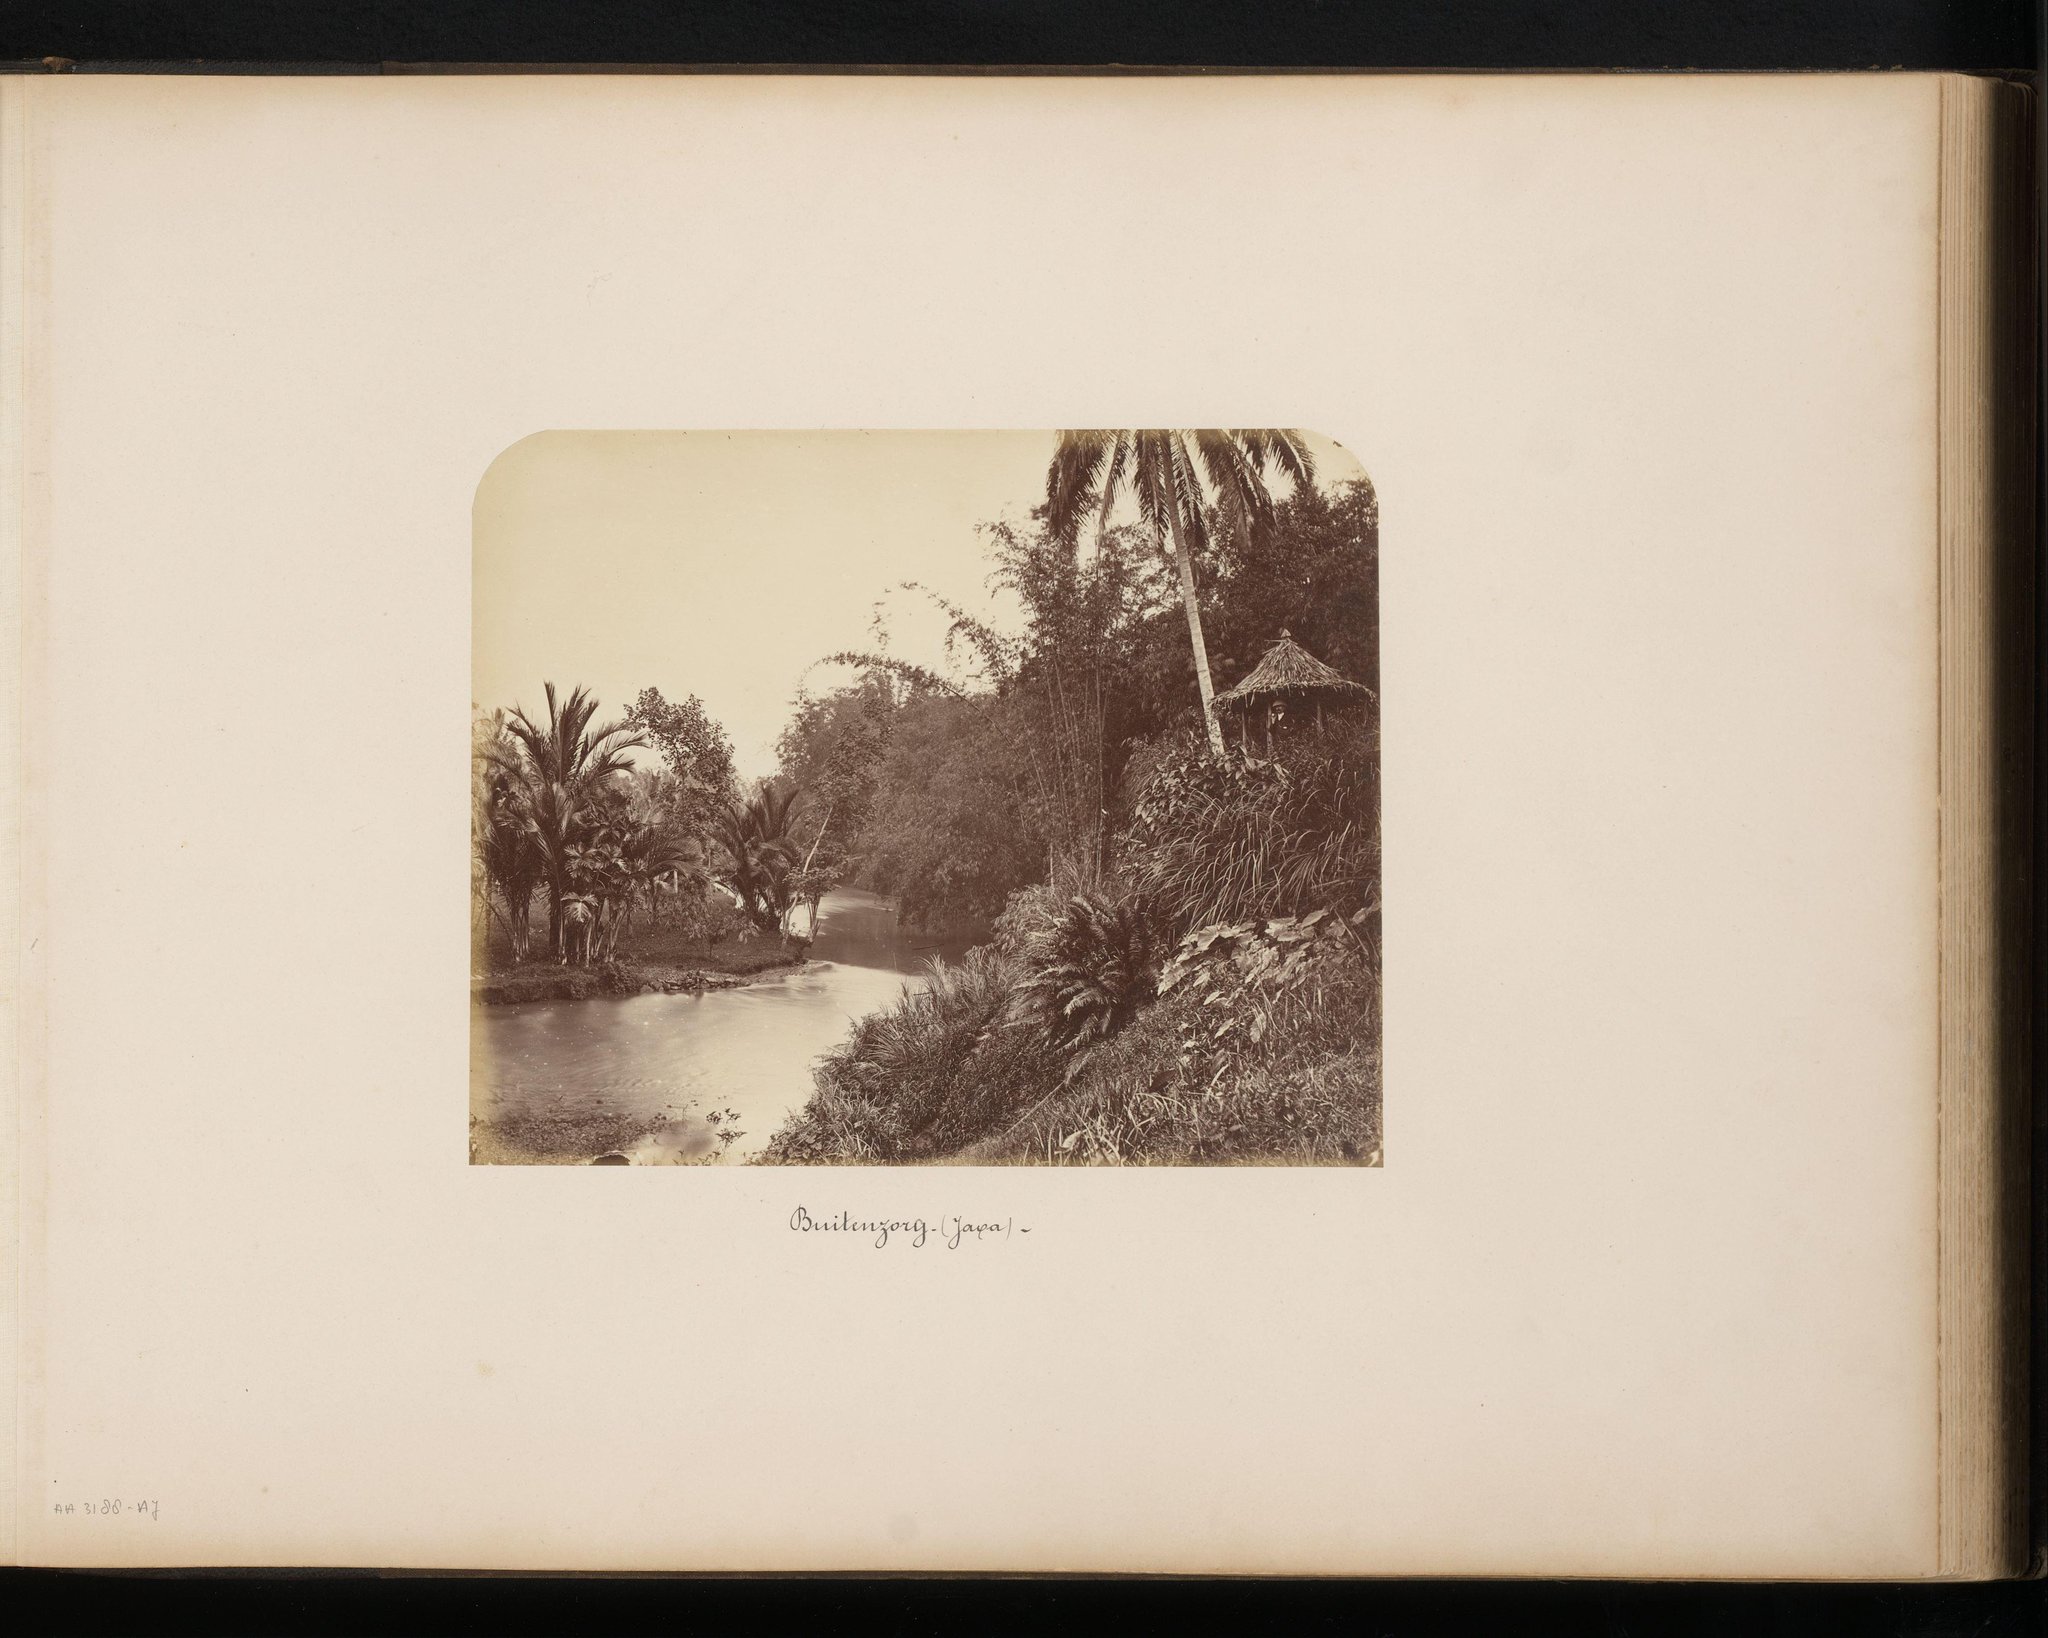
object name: photograph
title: Rivierlandschap bij Buitenzorg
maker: Anonymous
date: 1880-1883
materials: photographic support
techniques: albumen print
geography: buitenzorg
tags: river bank, river (+ landscape with figures, staffage)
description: Onderdeel van Reisalbum met opnames van bezienswaardigheden in Egypte, Nederlands-Indië, Singapore en Ceylon.